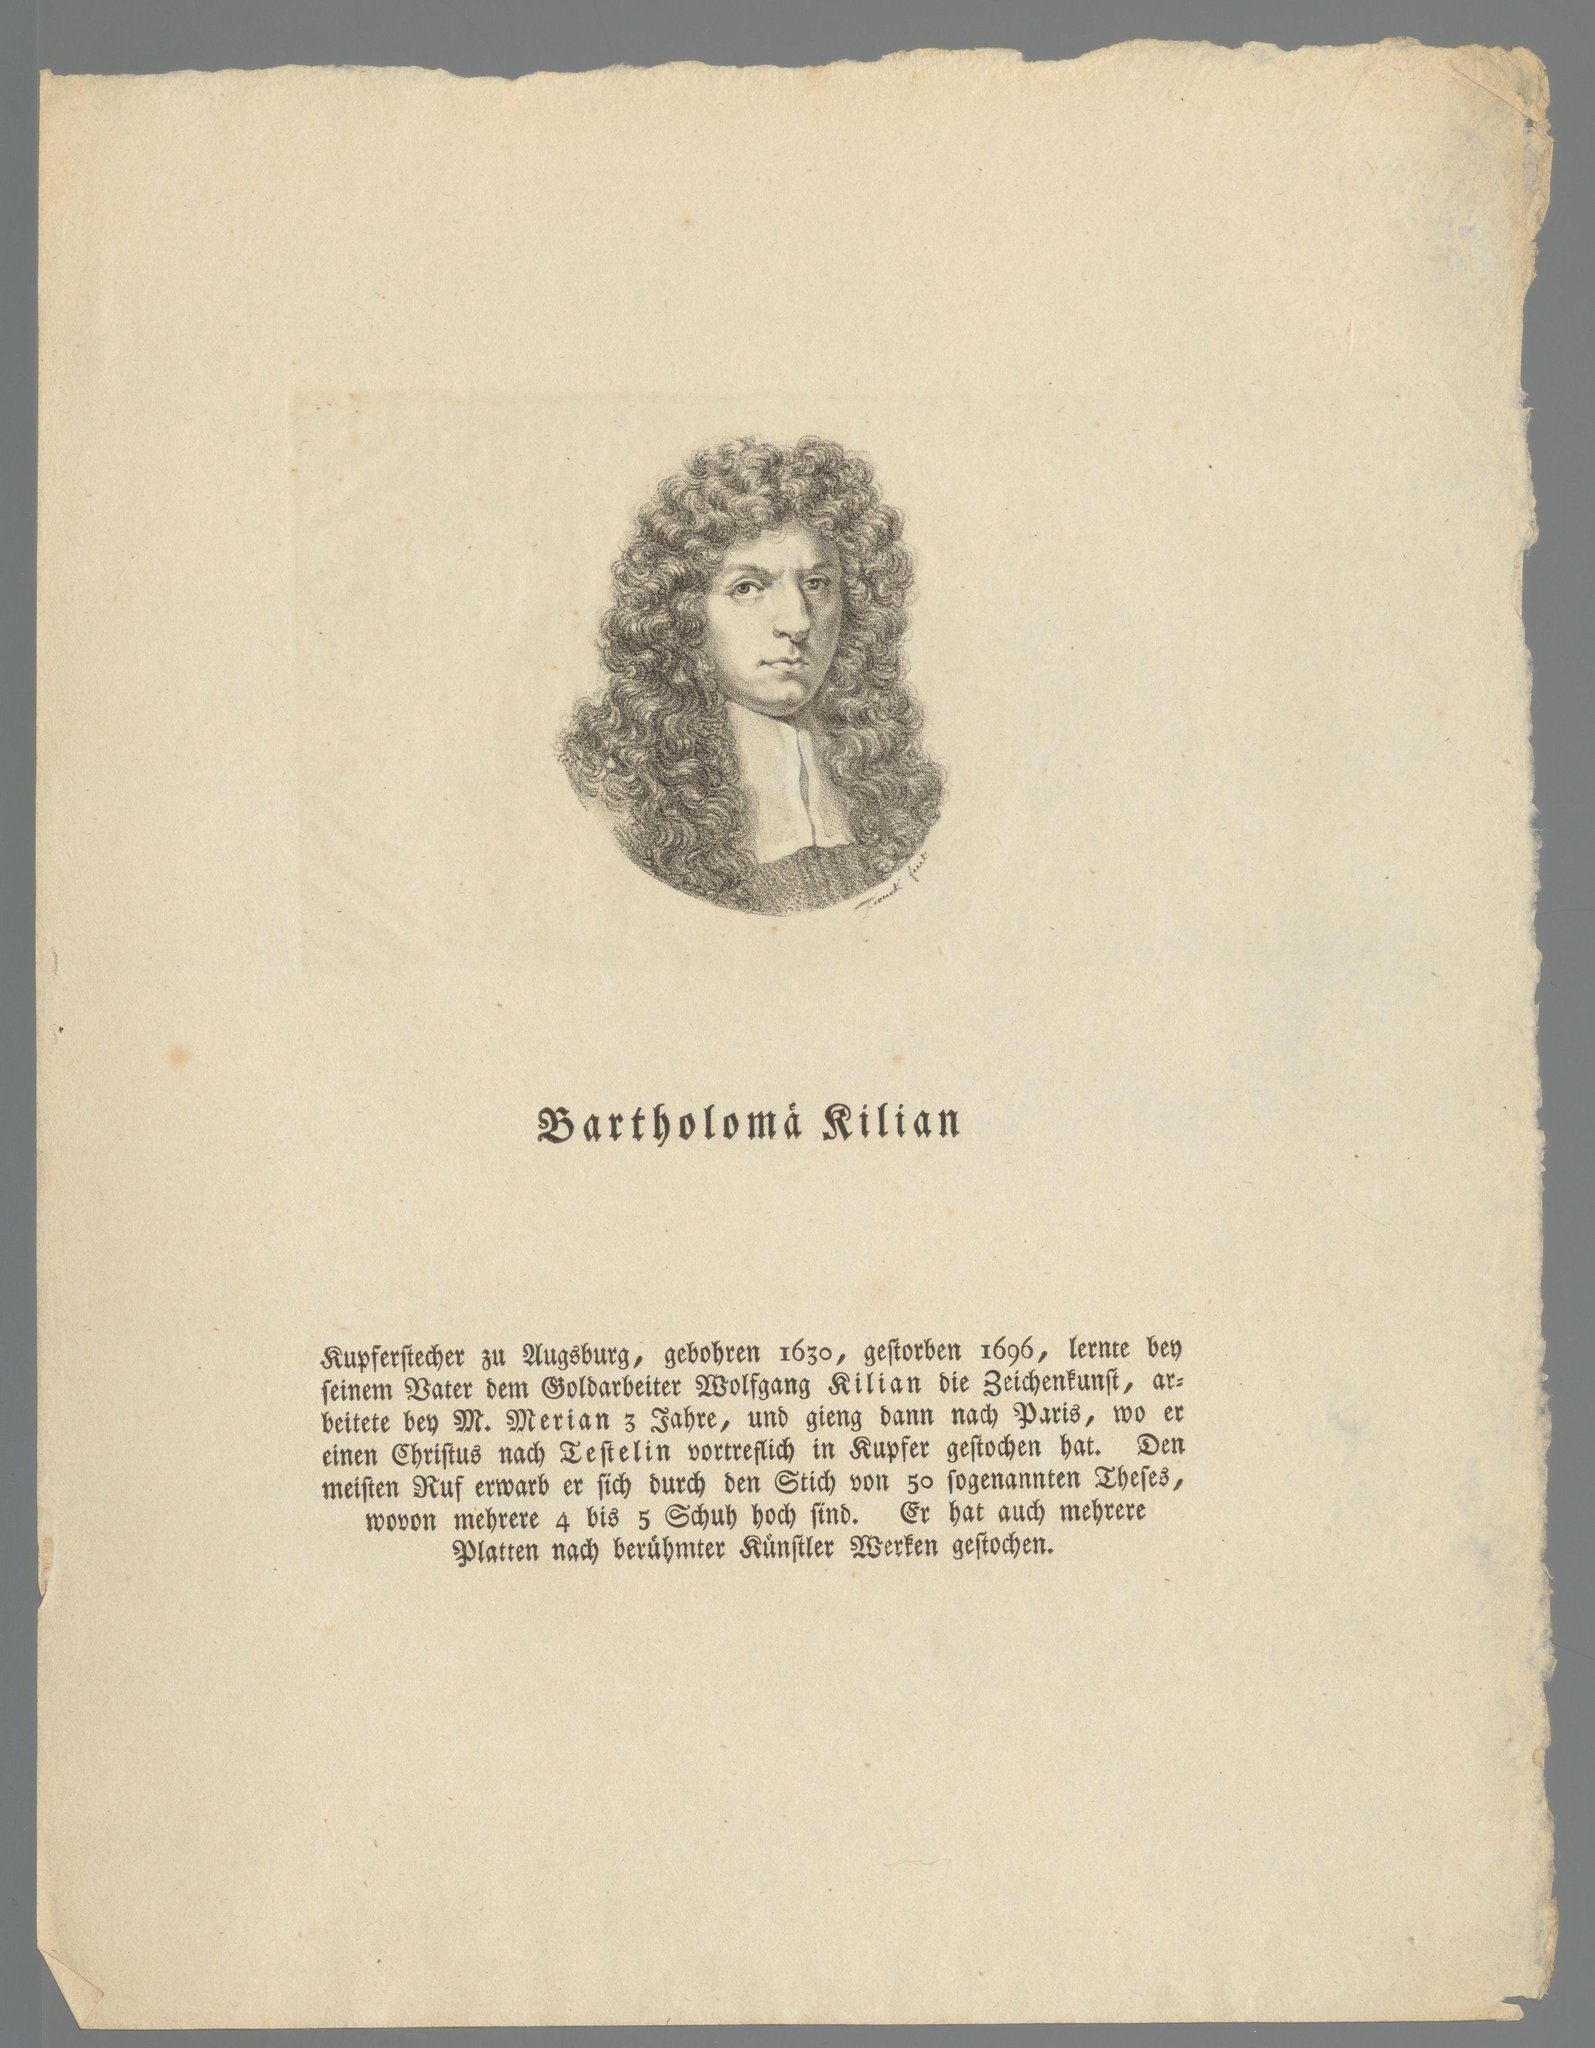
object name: book illustration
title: Portret van Bartholomäus Kilian (II)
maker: maximilian franck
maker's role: print maker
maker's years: 1780-1830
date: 1813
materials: paper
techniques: letterpress printing, lithograph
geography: munich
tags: augsburg, artist, publisher, bartholomäus kilian (ii), historical persons, portrait, self-portrait of painter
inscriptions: collector's mark: Lugt 2228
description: Prent uit: Lindauer, Joseph. Deutsche Künstler-Gallerie. München: Maximilian Franck, 1813.